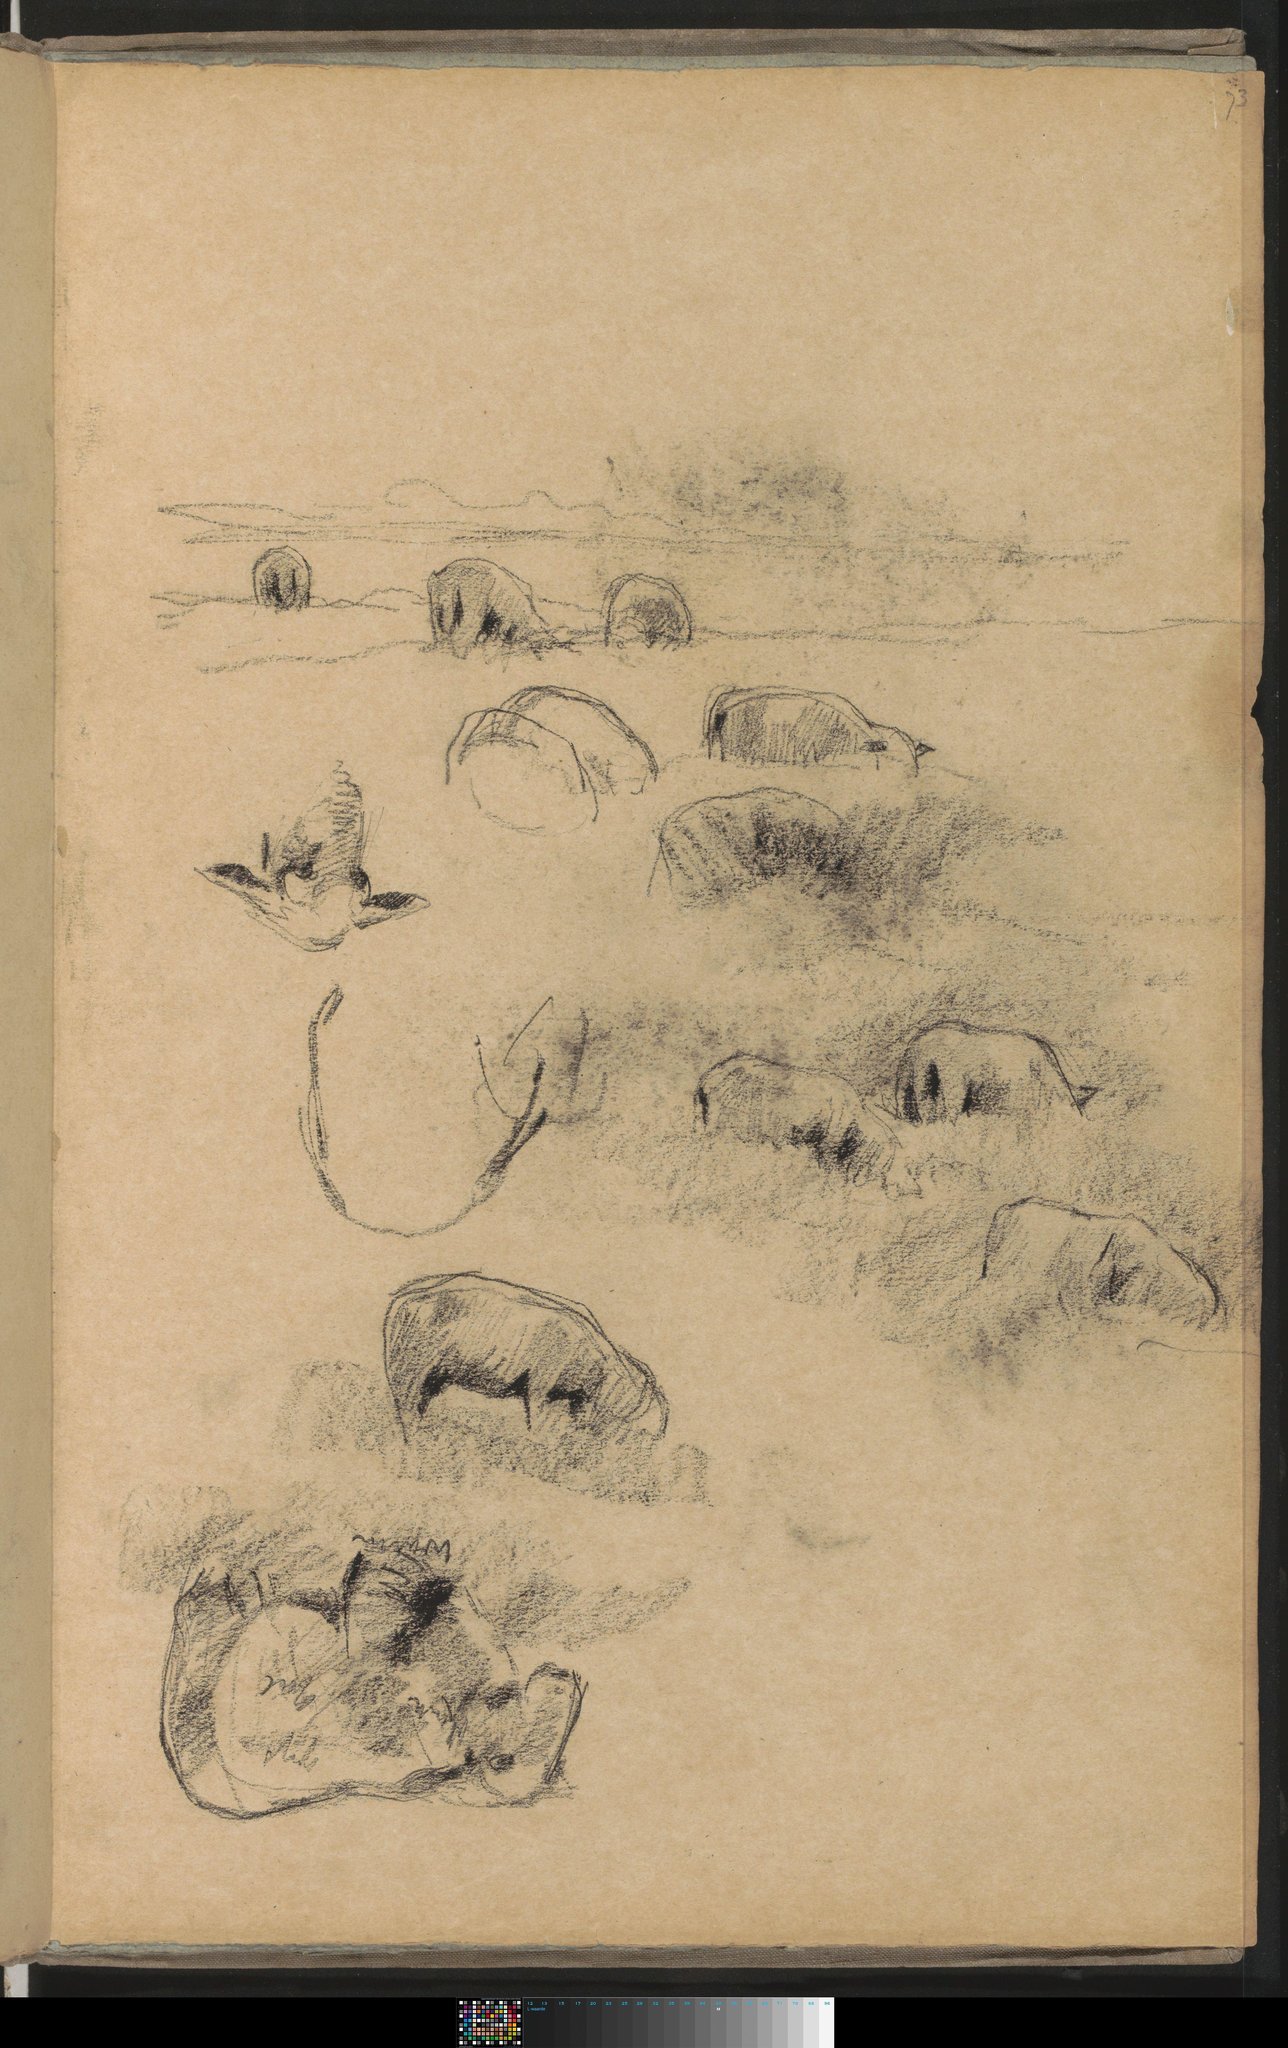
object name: sketchbook leaf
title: Studieblad met schapen, deels in een landschap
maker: willem witsen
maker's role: draughtsman, painter, print maker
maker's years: 1860-1923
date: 1884-1887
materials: chalk, paper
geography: ewijkshoeve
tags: landscapes in the temperate zone, sheep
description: Pagina 73 uit een schetsboek met 42 bladen vervaardigd rond de Ewijkshoeve.